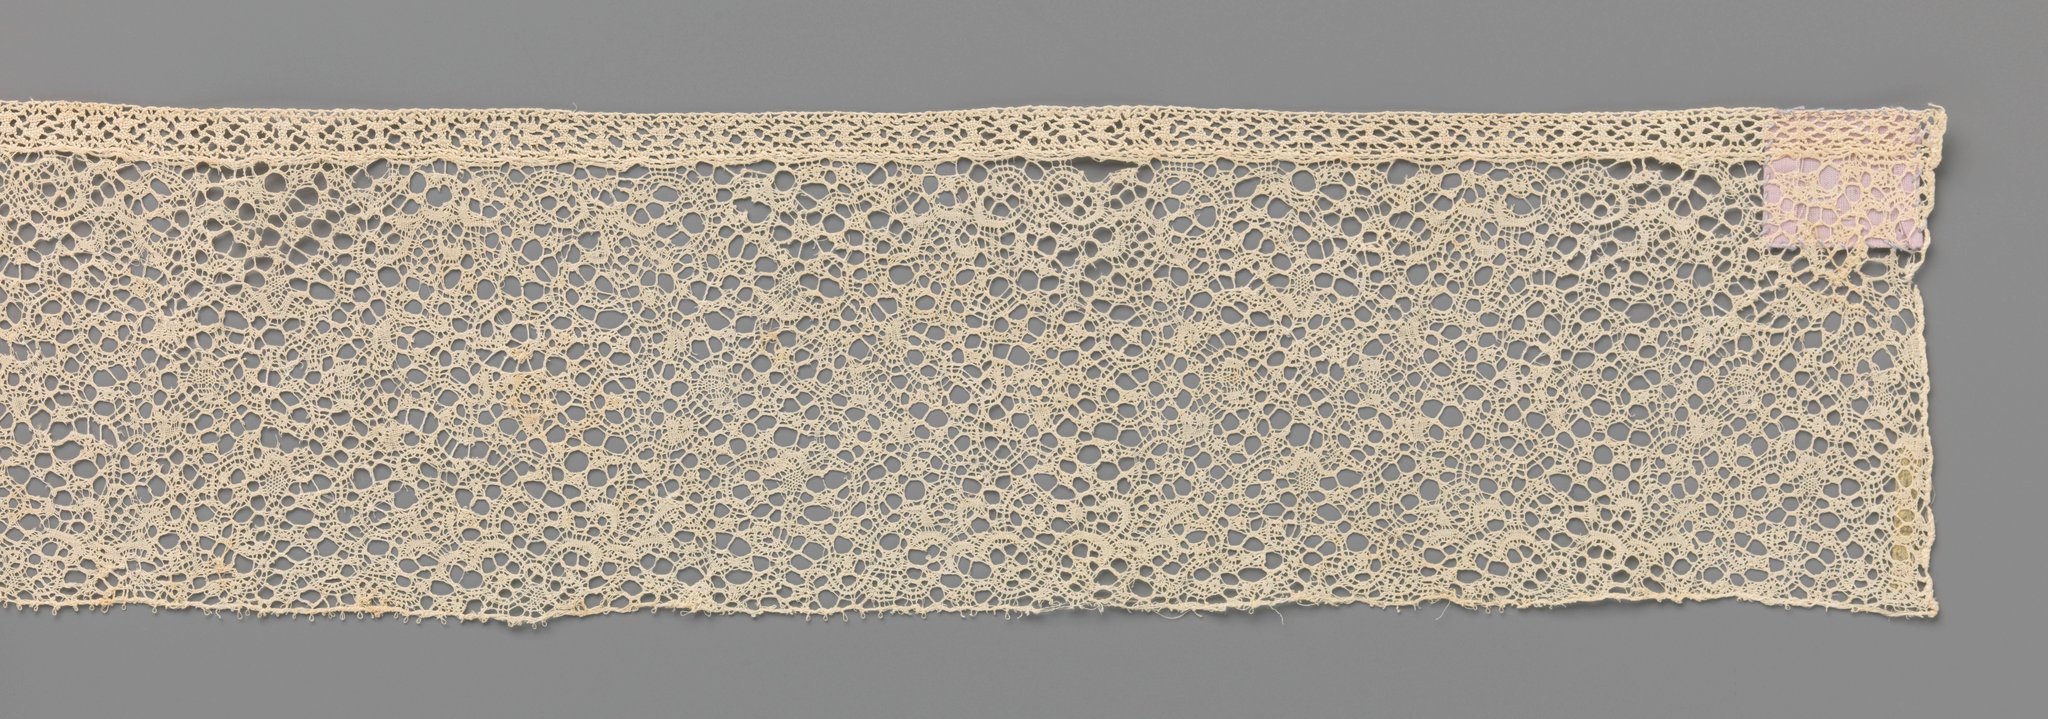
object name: strip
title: Strook kloskant met een wirwar van motiefjes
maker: Anonymous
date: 1675-1699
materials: linen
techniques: lace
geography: southern netherlands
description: Strook naturelkleurige kloskant, Binche-kant. Het zich herhalende patroon bestaat uit wirwar van kleine motiefjes gemaakt met verschillende siergronden. De motieven zijn met elkaar verbonden door een onregelmatige siergrond, een sneeuwvlokkengrond. Het ijle, zeer spaarzaam toegepaste volwerk is gemaakt in linnenslag met opengewerkte randjes. De onderzijde van de strook is recht afgewerkt en voorzien van picots. De bovenzijde is afgewerkt met een apart geklost bandje.